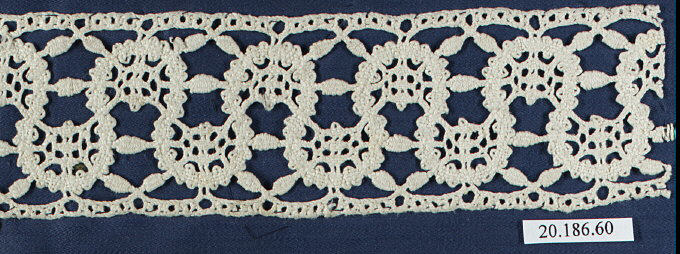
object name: insertion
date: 1601-1700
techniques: lace